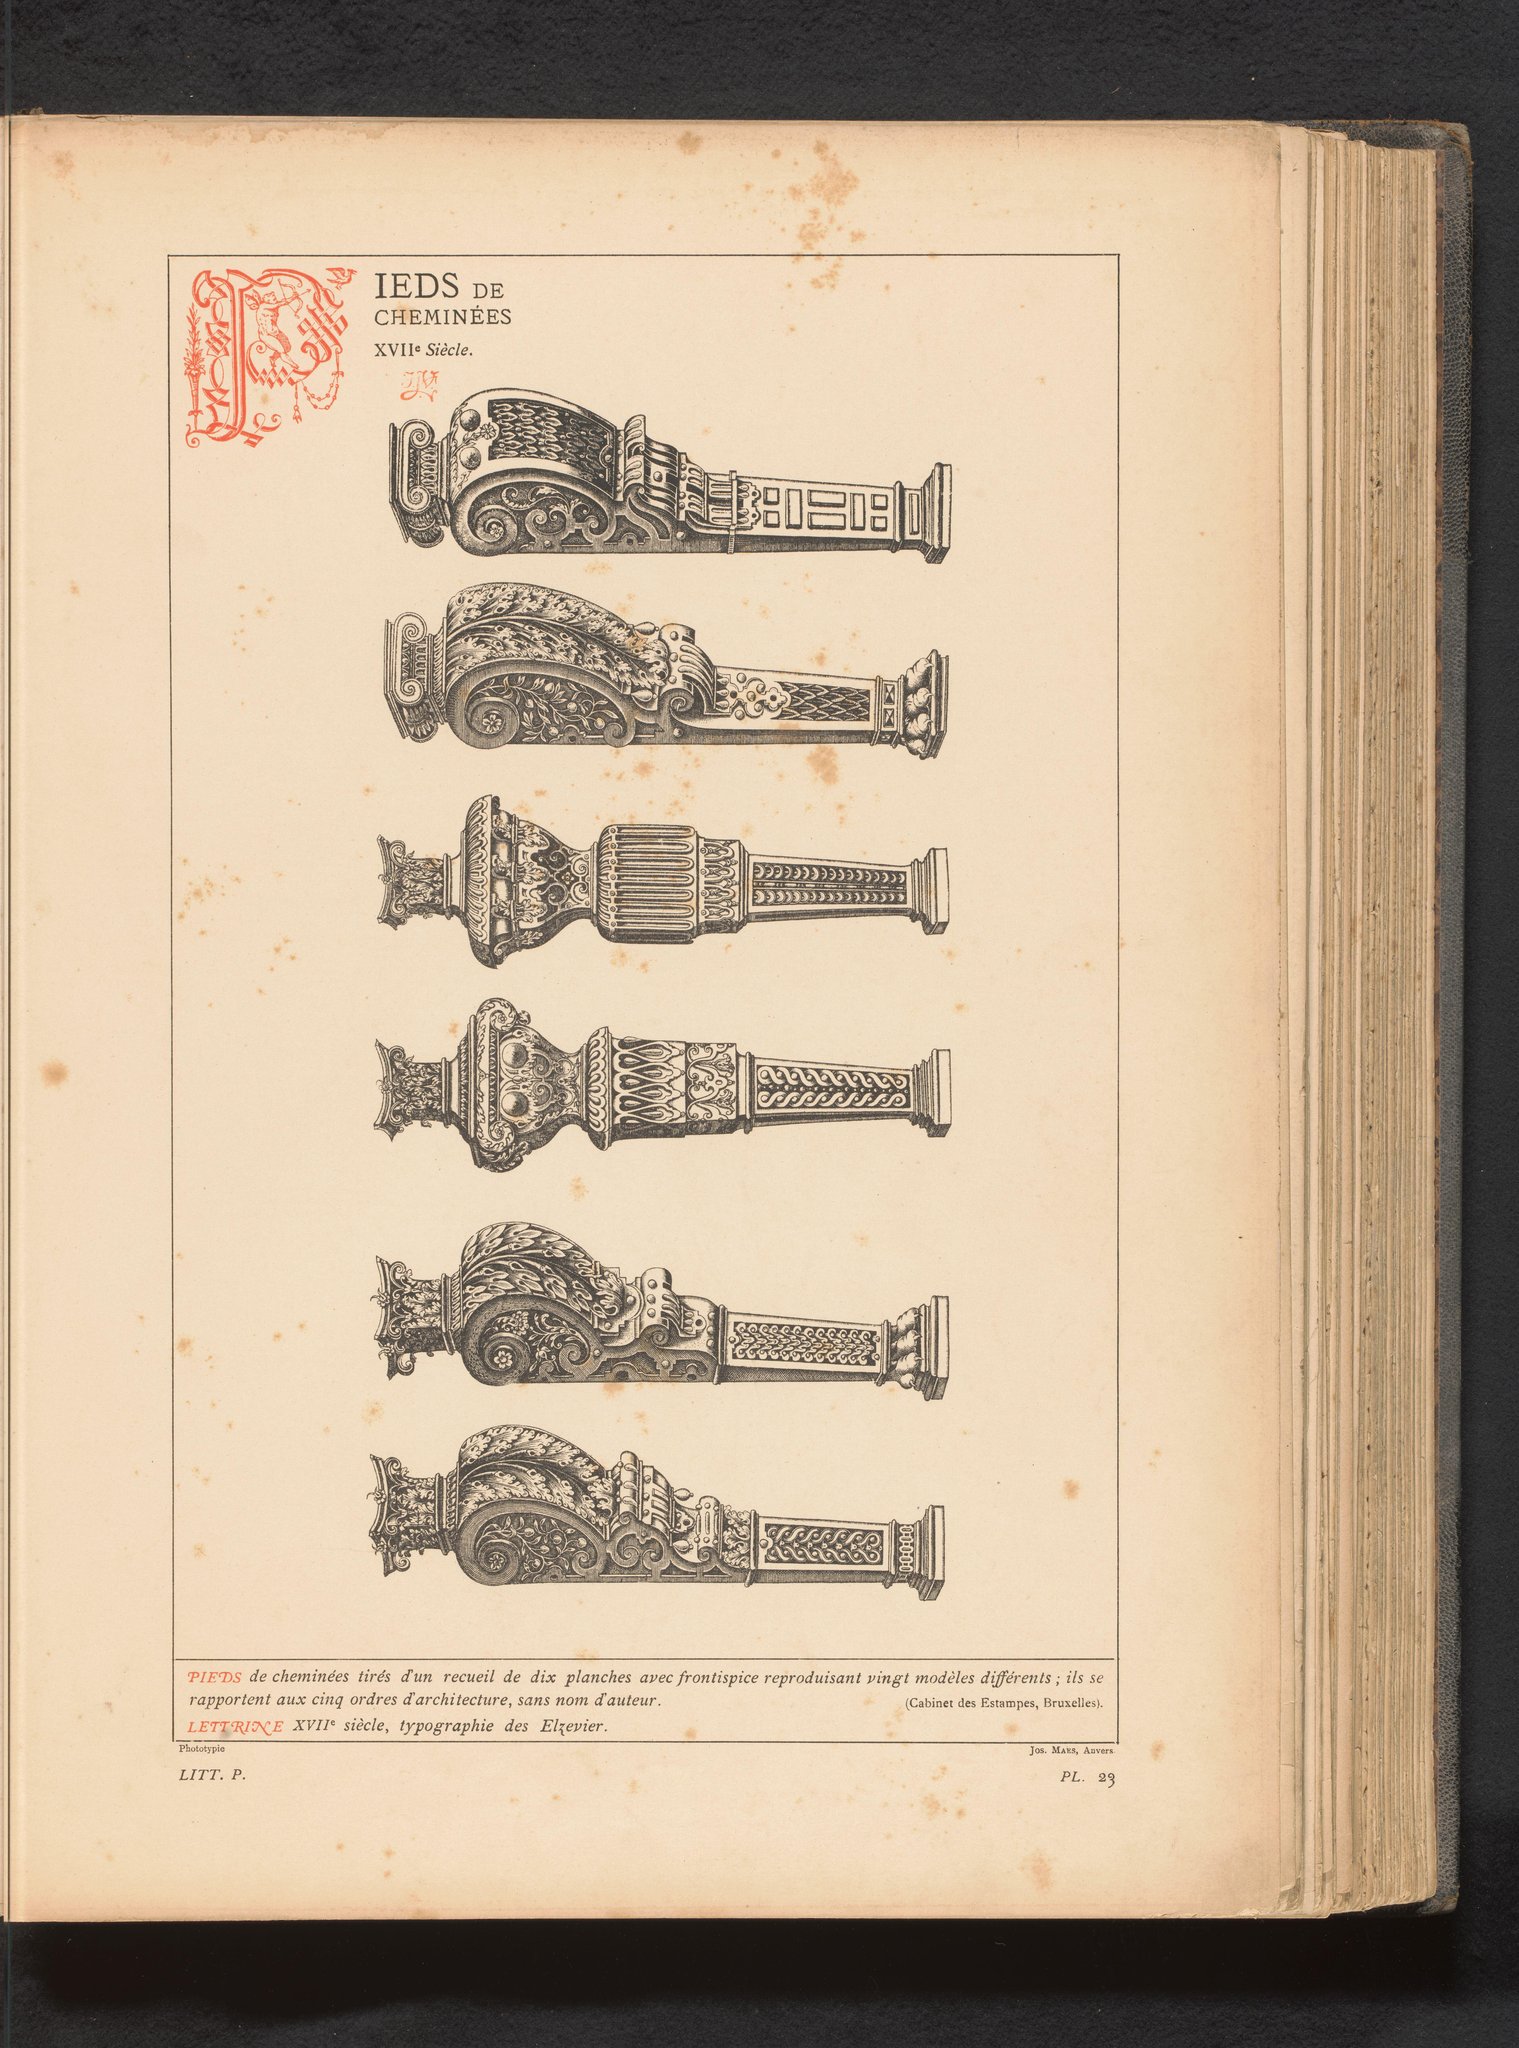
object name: page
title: Reproductie van een prent van gedecoreerde delen van een open haard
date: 1876-1881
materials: paper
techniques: photolithography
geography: antwerp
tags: open hearth, fire-place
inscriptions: monogram: ‘JJvY’, inscription: ‘LITT. P. - PL. 23.’, inscription: ‘PIEDS de cheminées (...)’